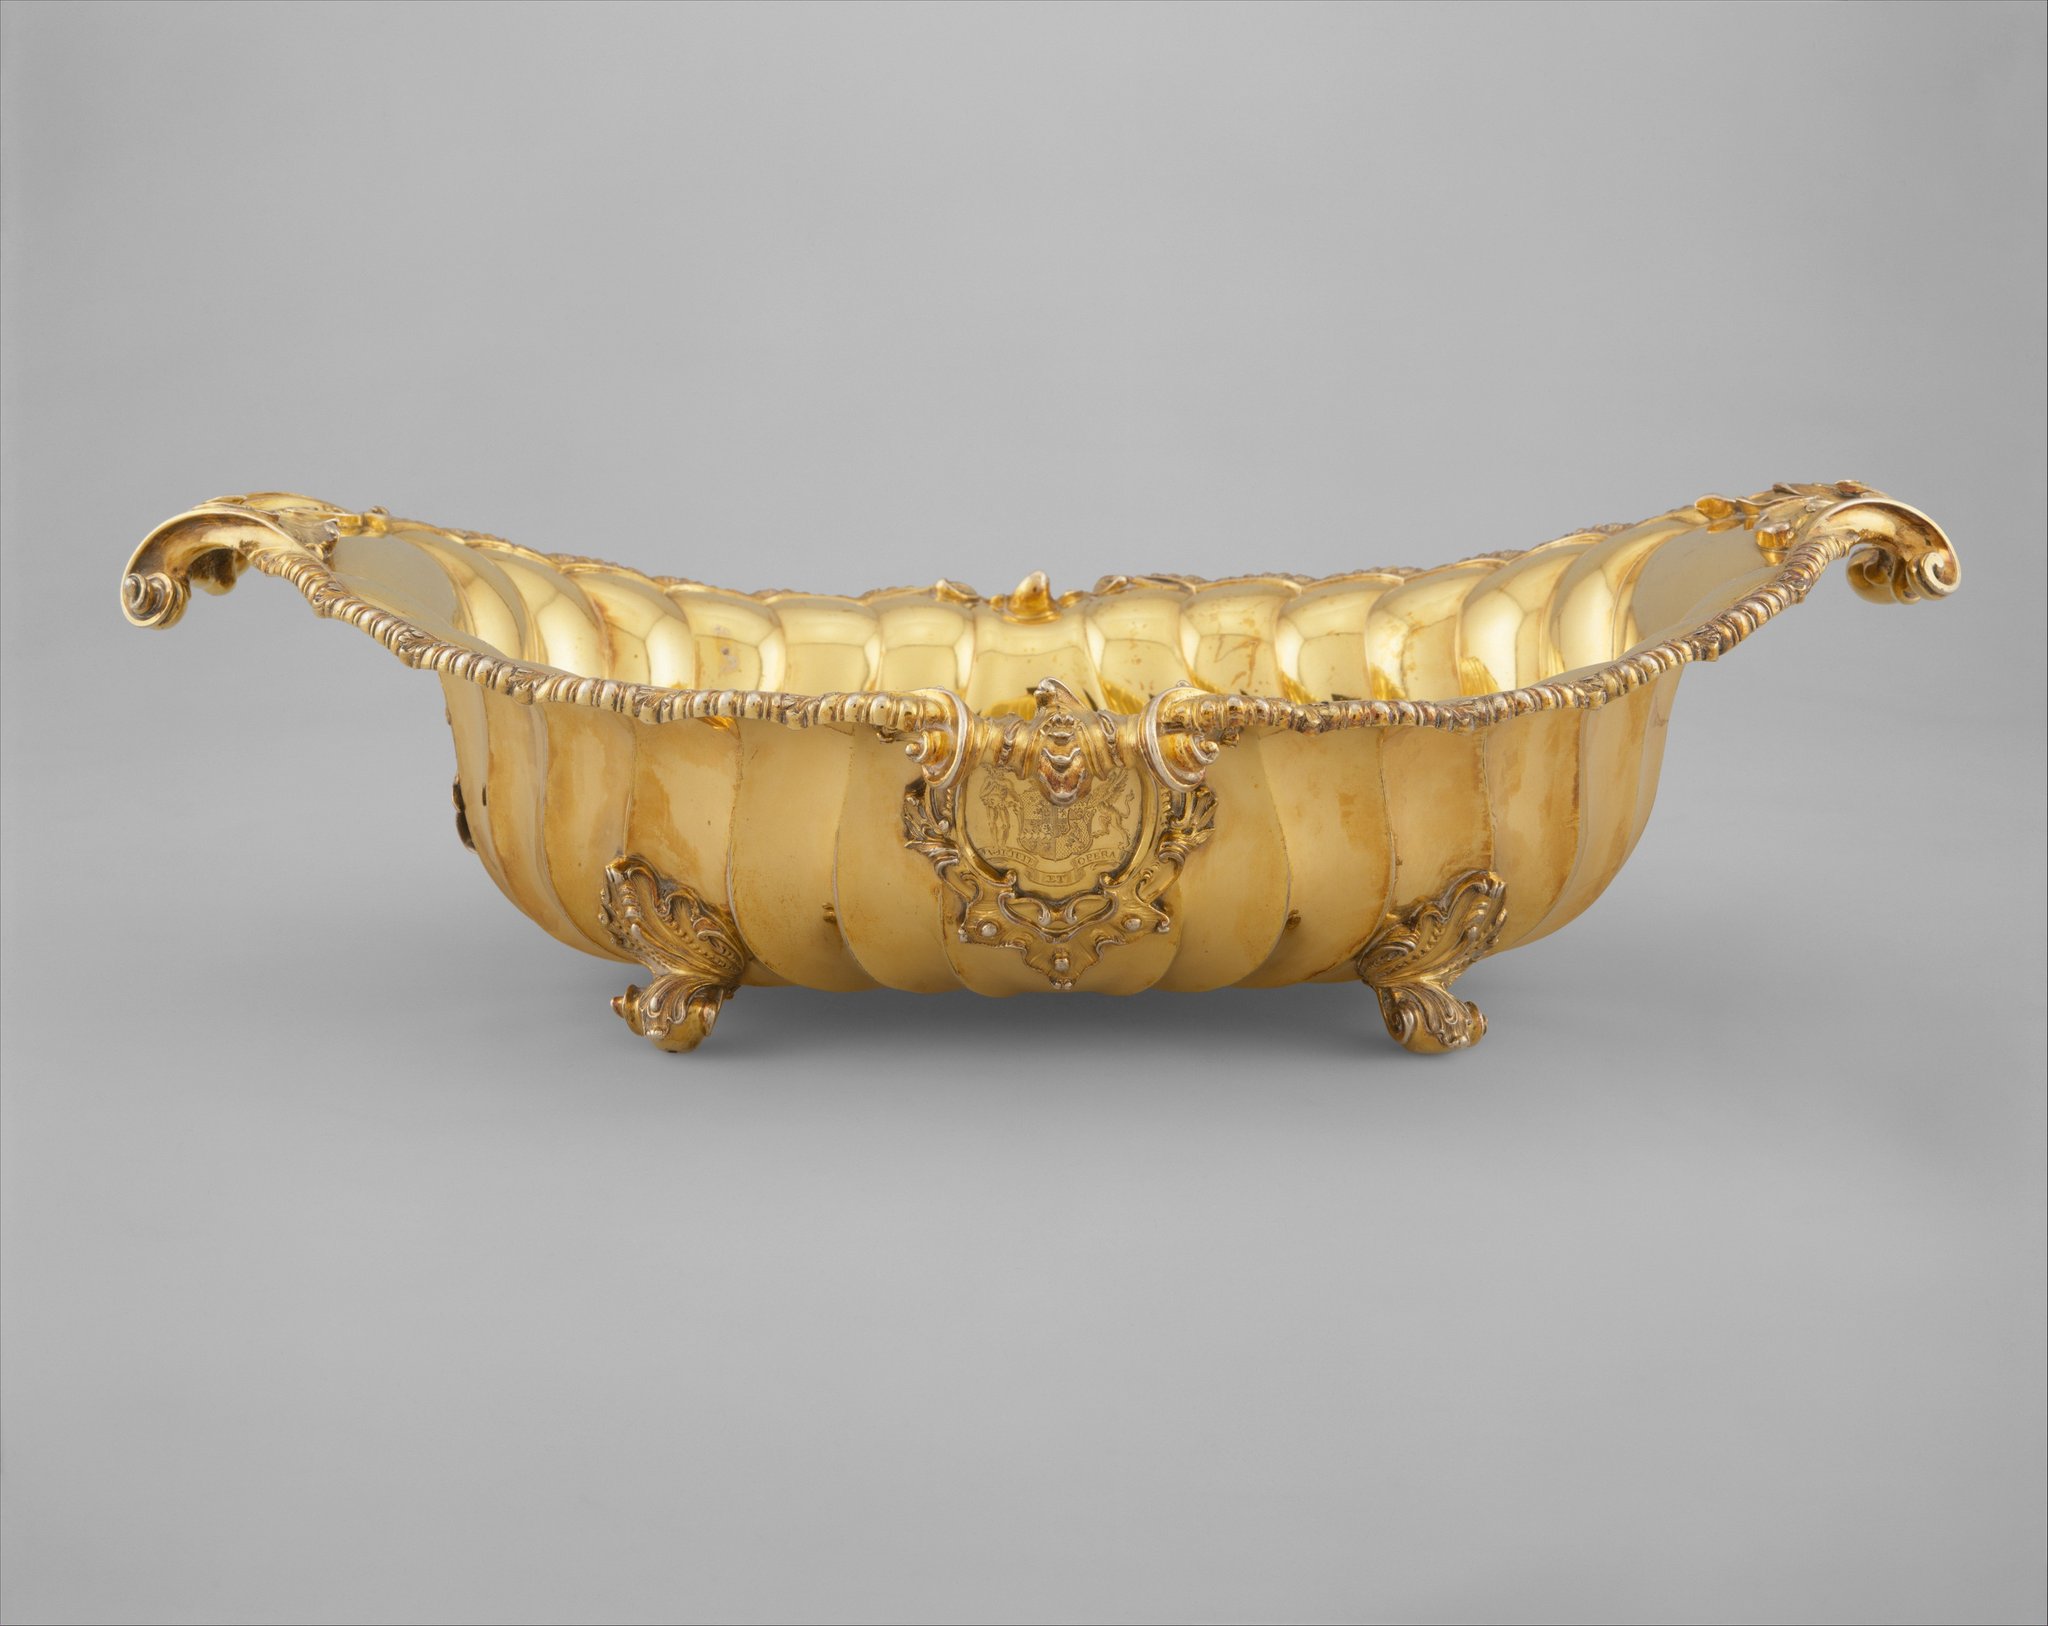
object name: fruit dish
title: Fruit dish (one of a pair)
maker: thomas heming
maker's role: maker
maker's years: 1745-1773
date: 1766-1767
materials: silver gilt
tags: coat of arms